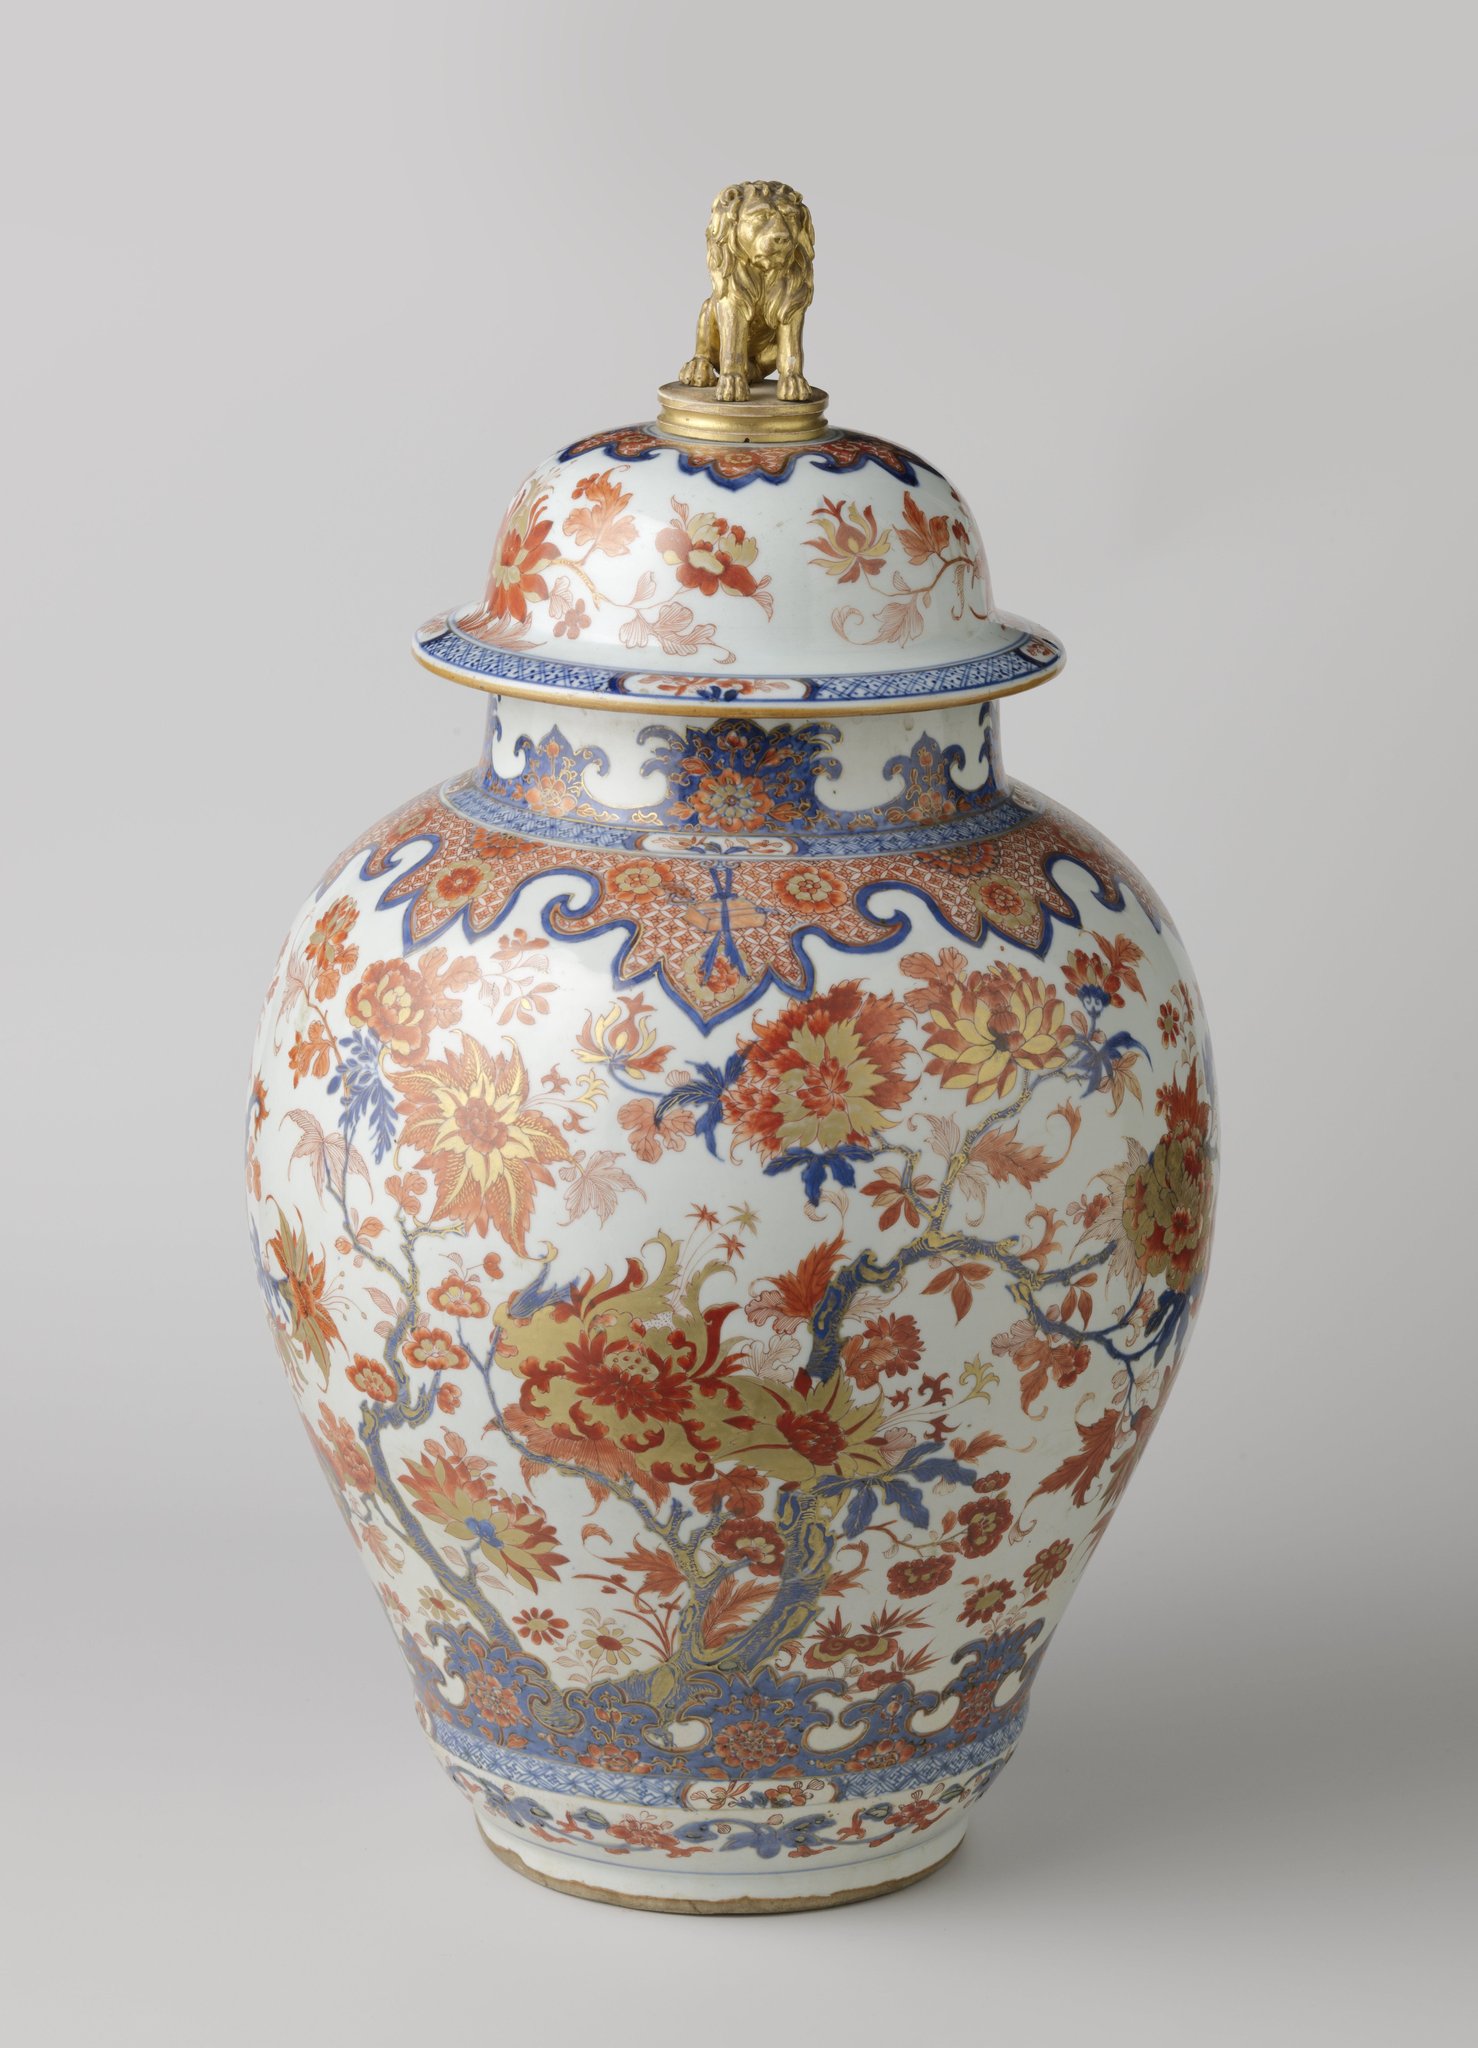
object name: covered jar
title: Covered baluster jar with large flower sprays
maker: Anonymous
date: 1720-1740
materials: cobalt, glaze, gold, paint, porcelain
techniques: firing, gilding, turning, vitrification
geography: japan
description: Dekselvaas, gedecoreerd in Imari-kleuren, met bloemtakken tussen decoratieve banden. Leeuw op deksel.